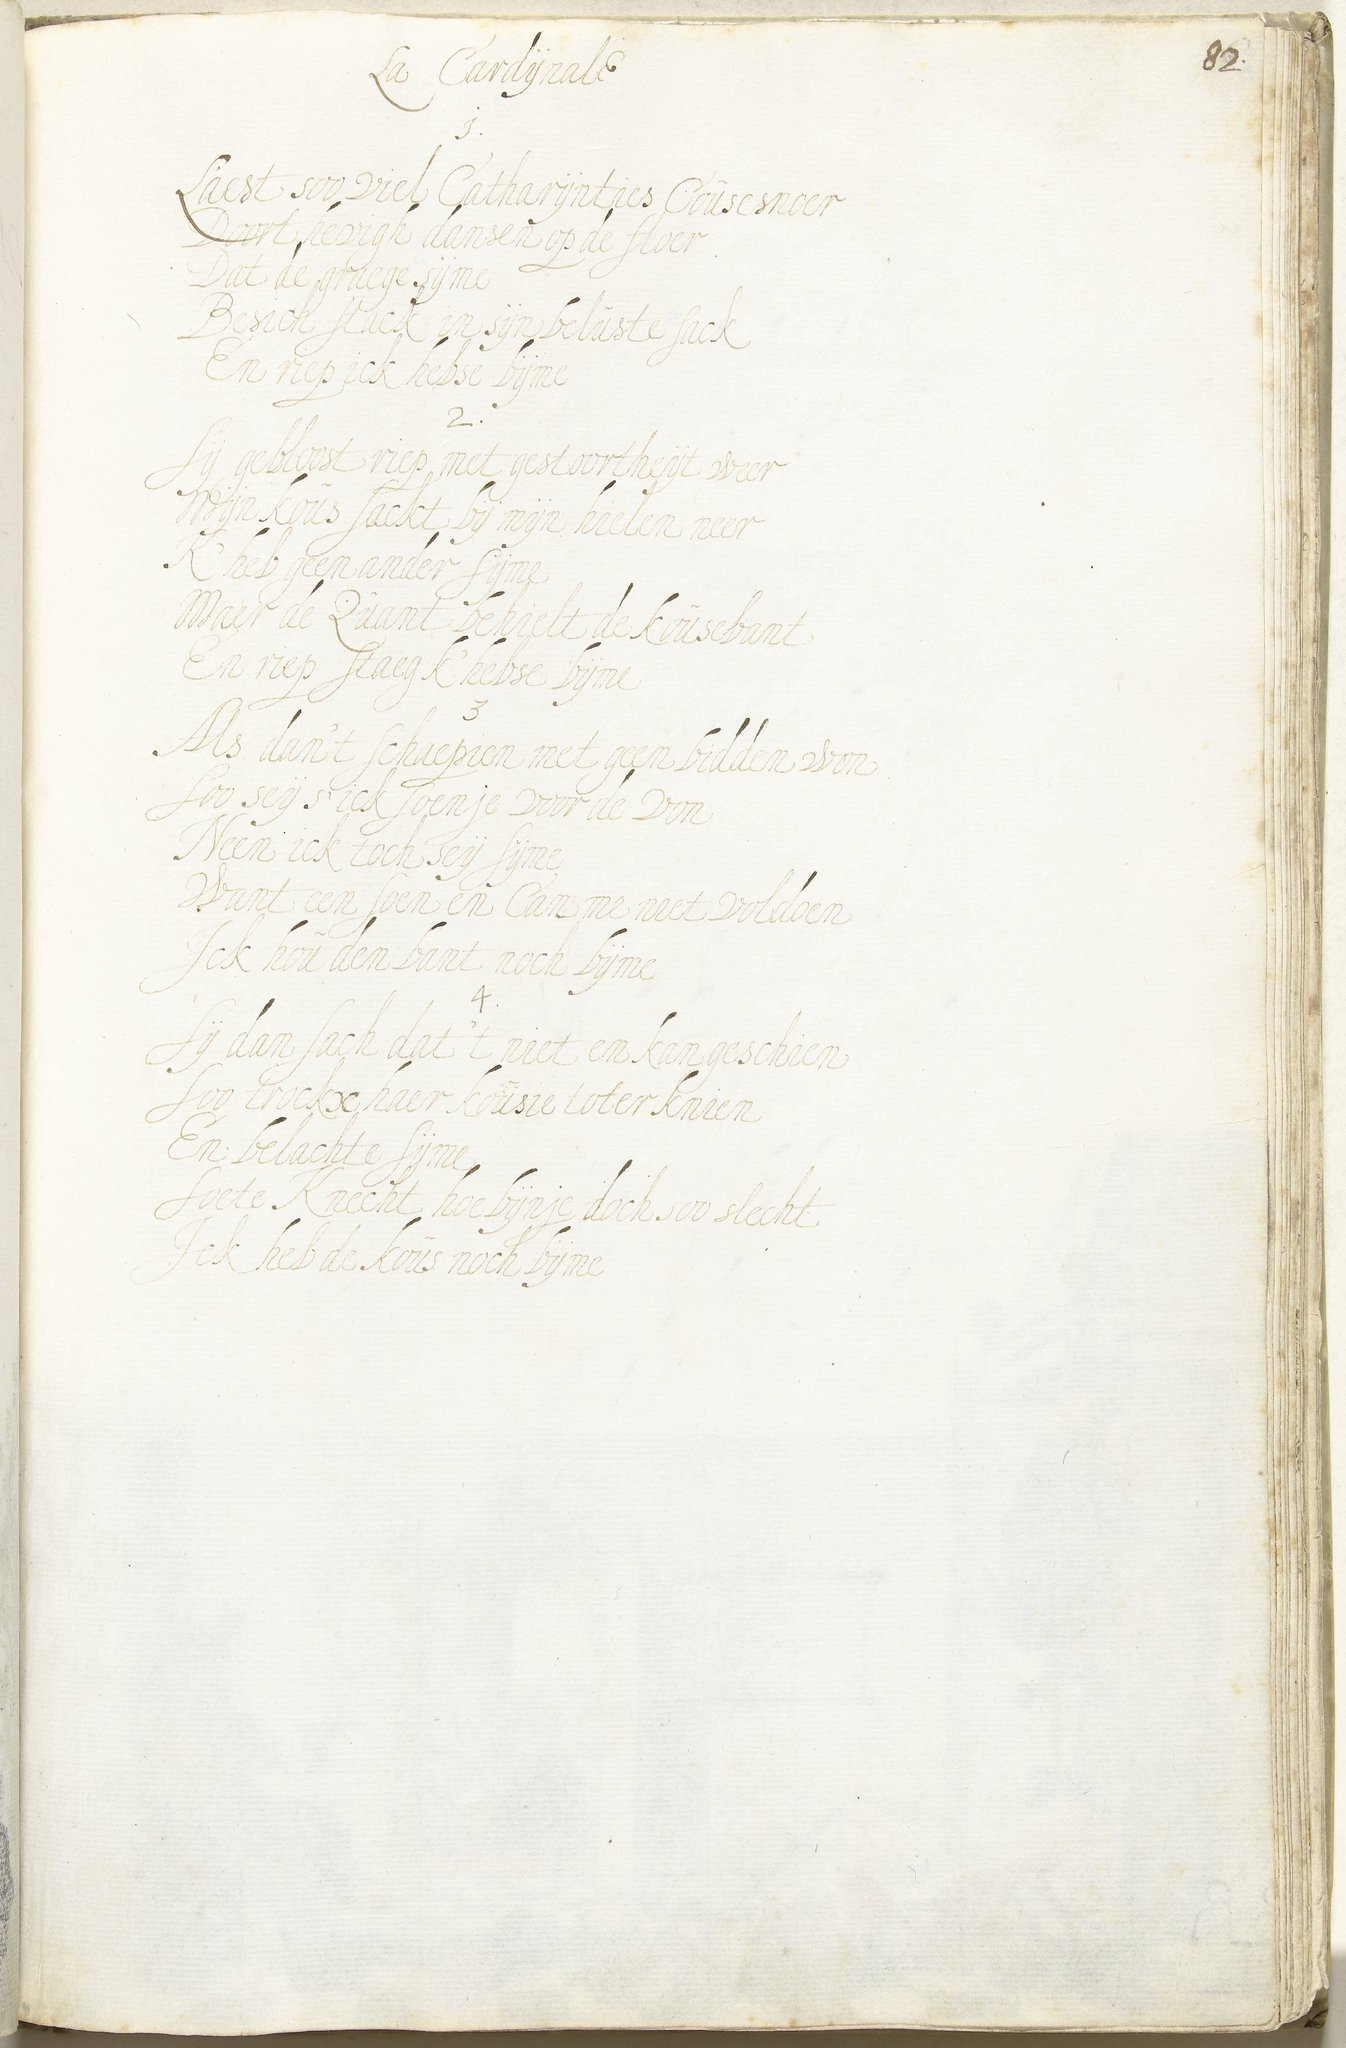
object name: calligraphy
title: Gedicht over Catharijntje die haar kousenband verliest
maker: gesina ter borch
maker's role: draughtsman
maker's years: 1633-1690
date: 1658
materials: ink, paper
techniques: calligraphy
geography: zwolle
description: Gedicht over Catharijntje die haar kousenband verliest op de dansvloer, op de melodie van La Cardijnale.